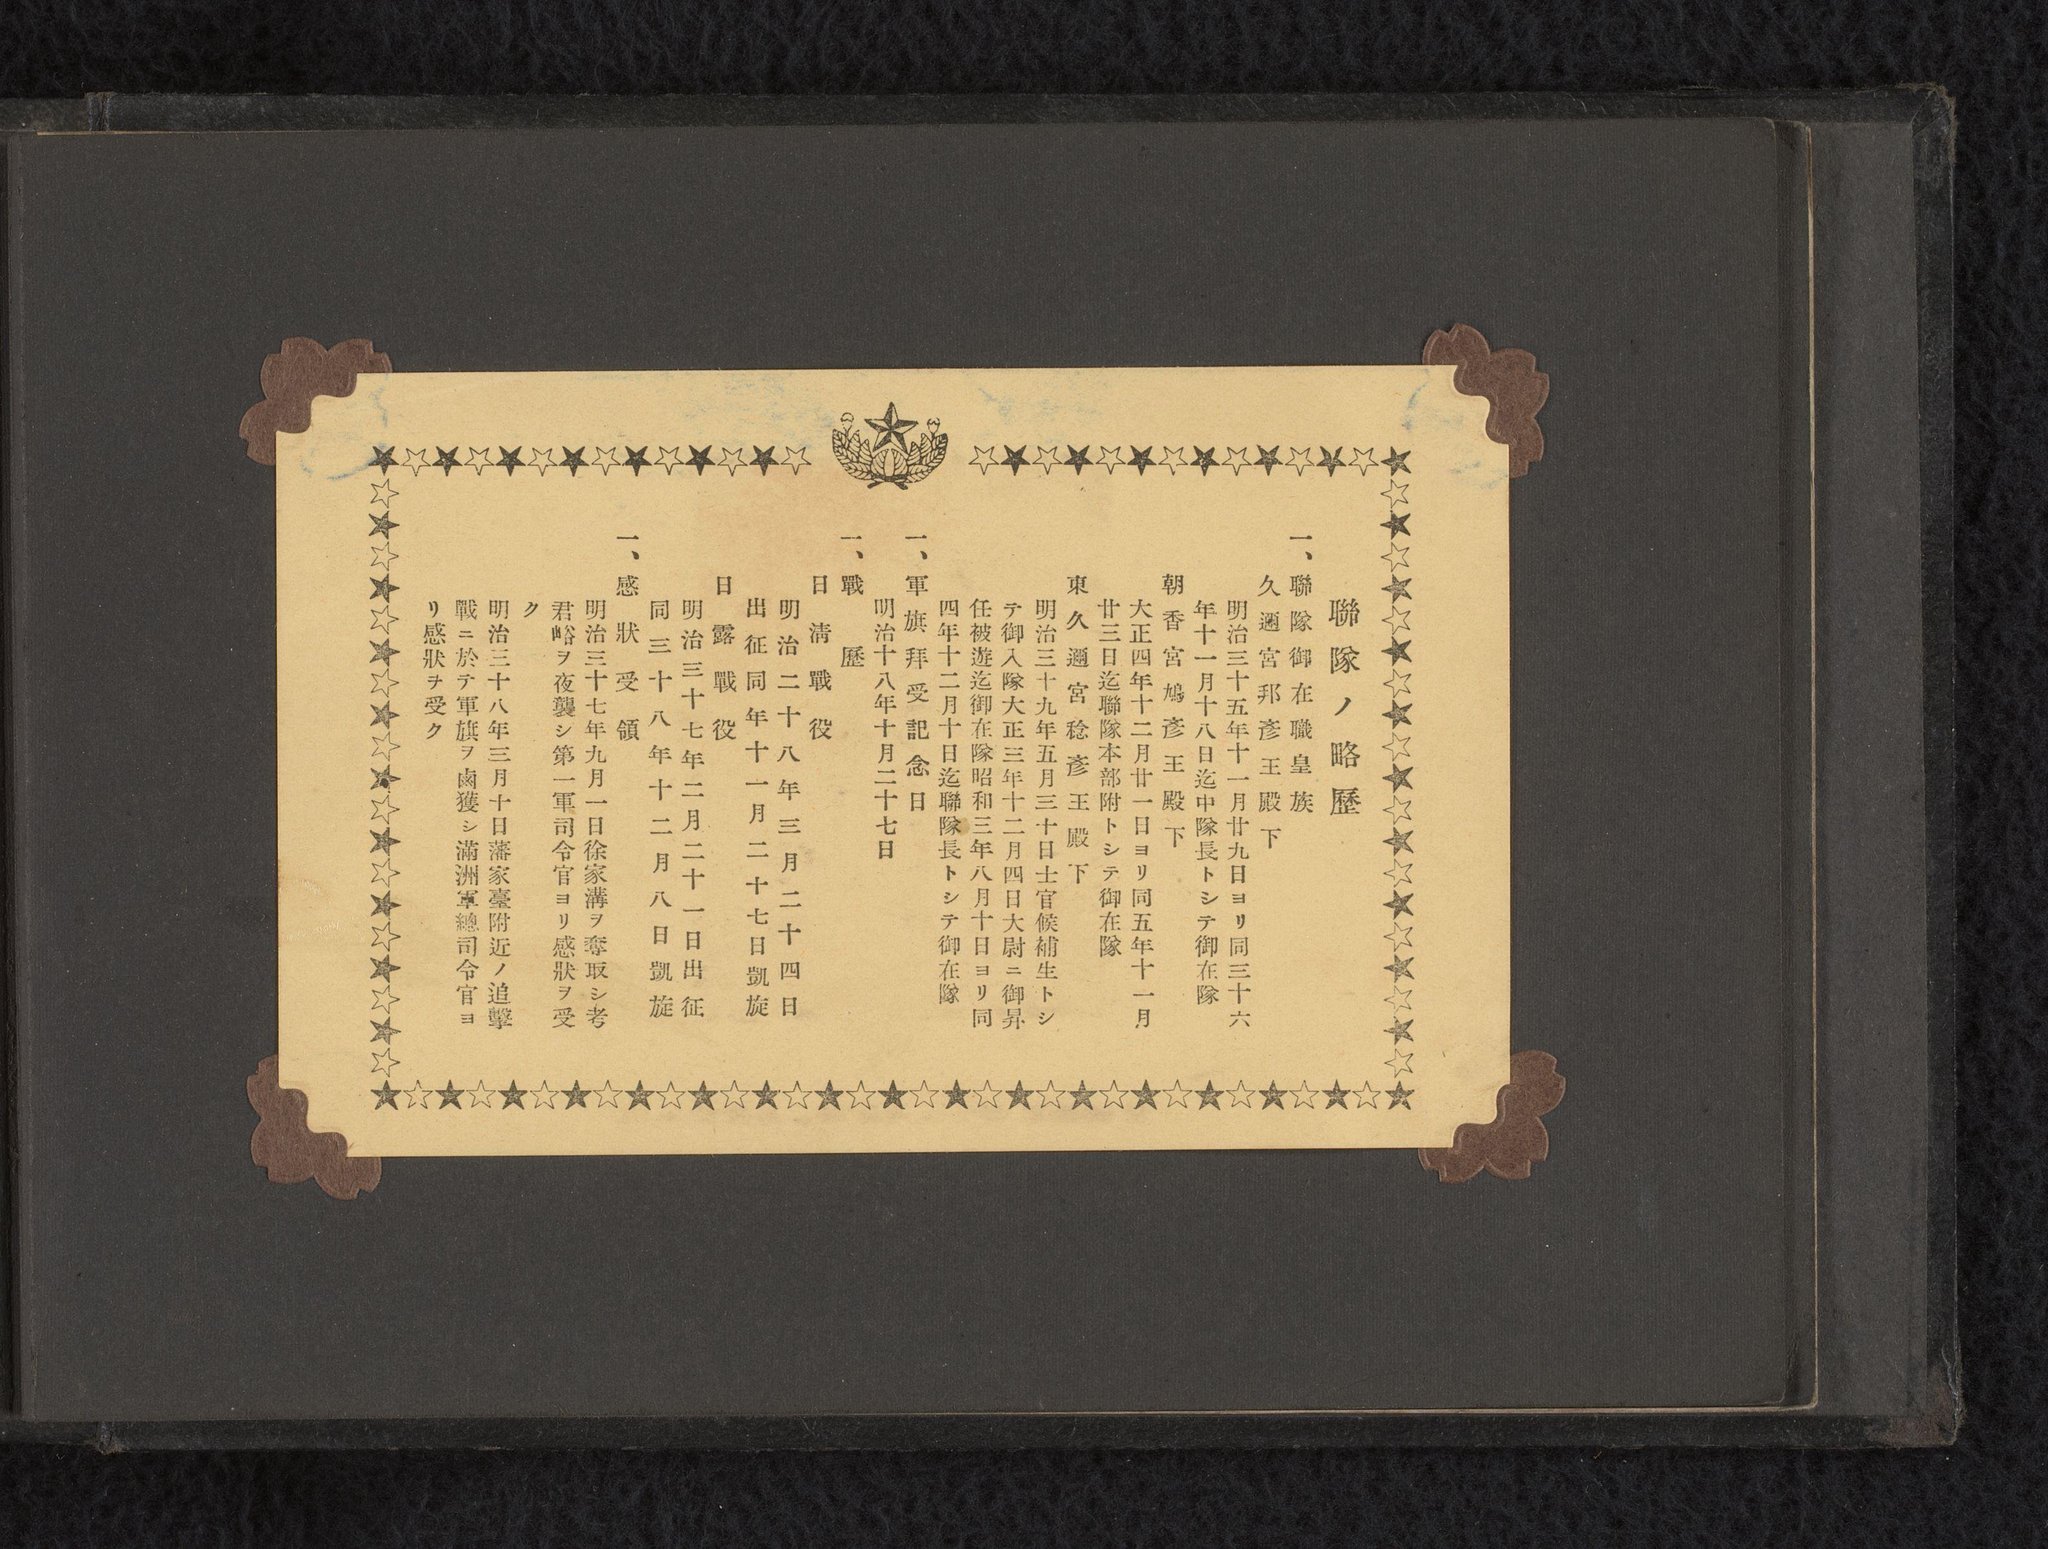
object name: album leaf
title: Tijdlijn van Japanse geschiedenis, van de geboorte van prins Kuni Kuniyoshi tot het Mantsjoerije-incident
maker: Anonymous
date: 1937-1941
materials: paper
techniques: printing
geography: japan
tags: calendar, almanac, japan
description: Dit document is onderdeel van een album.